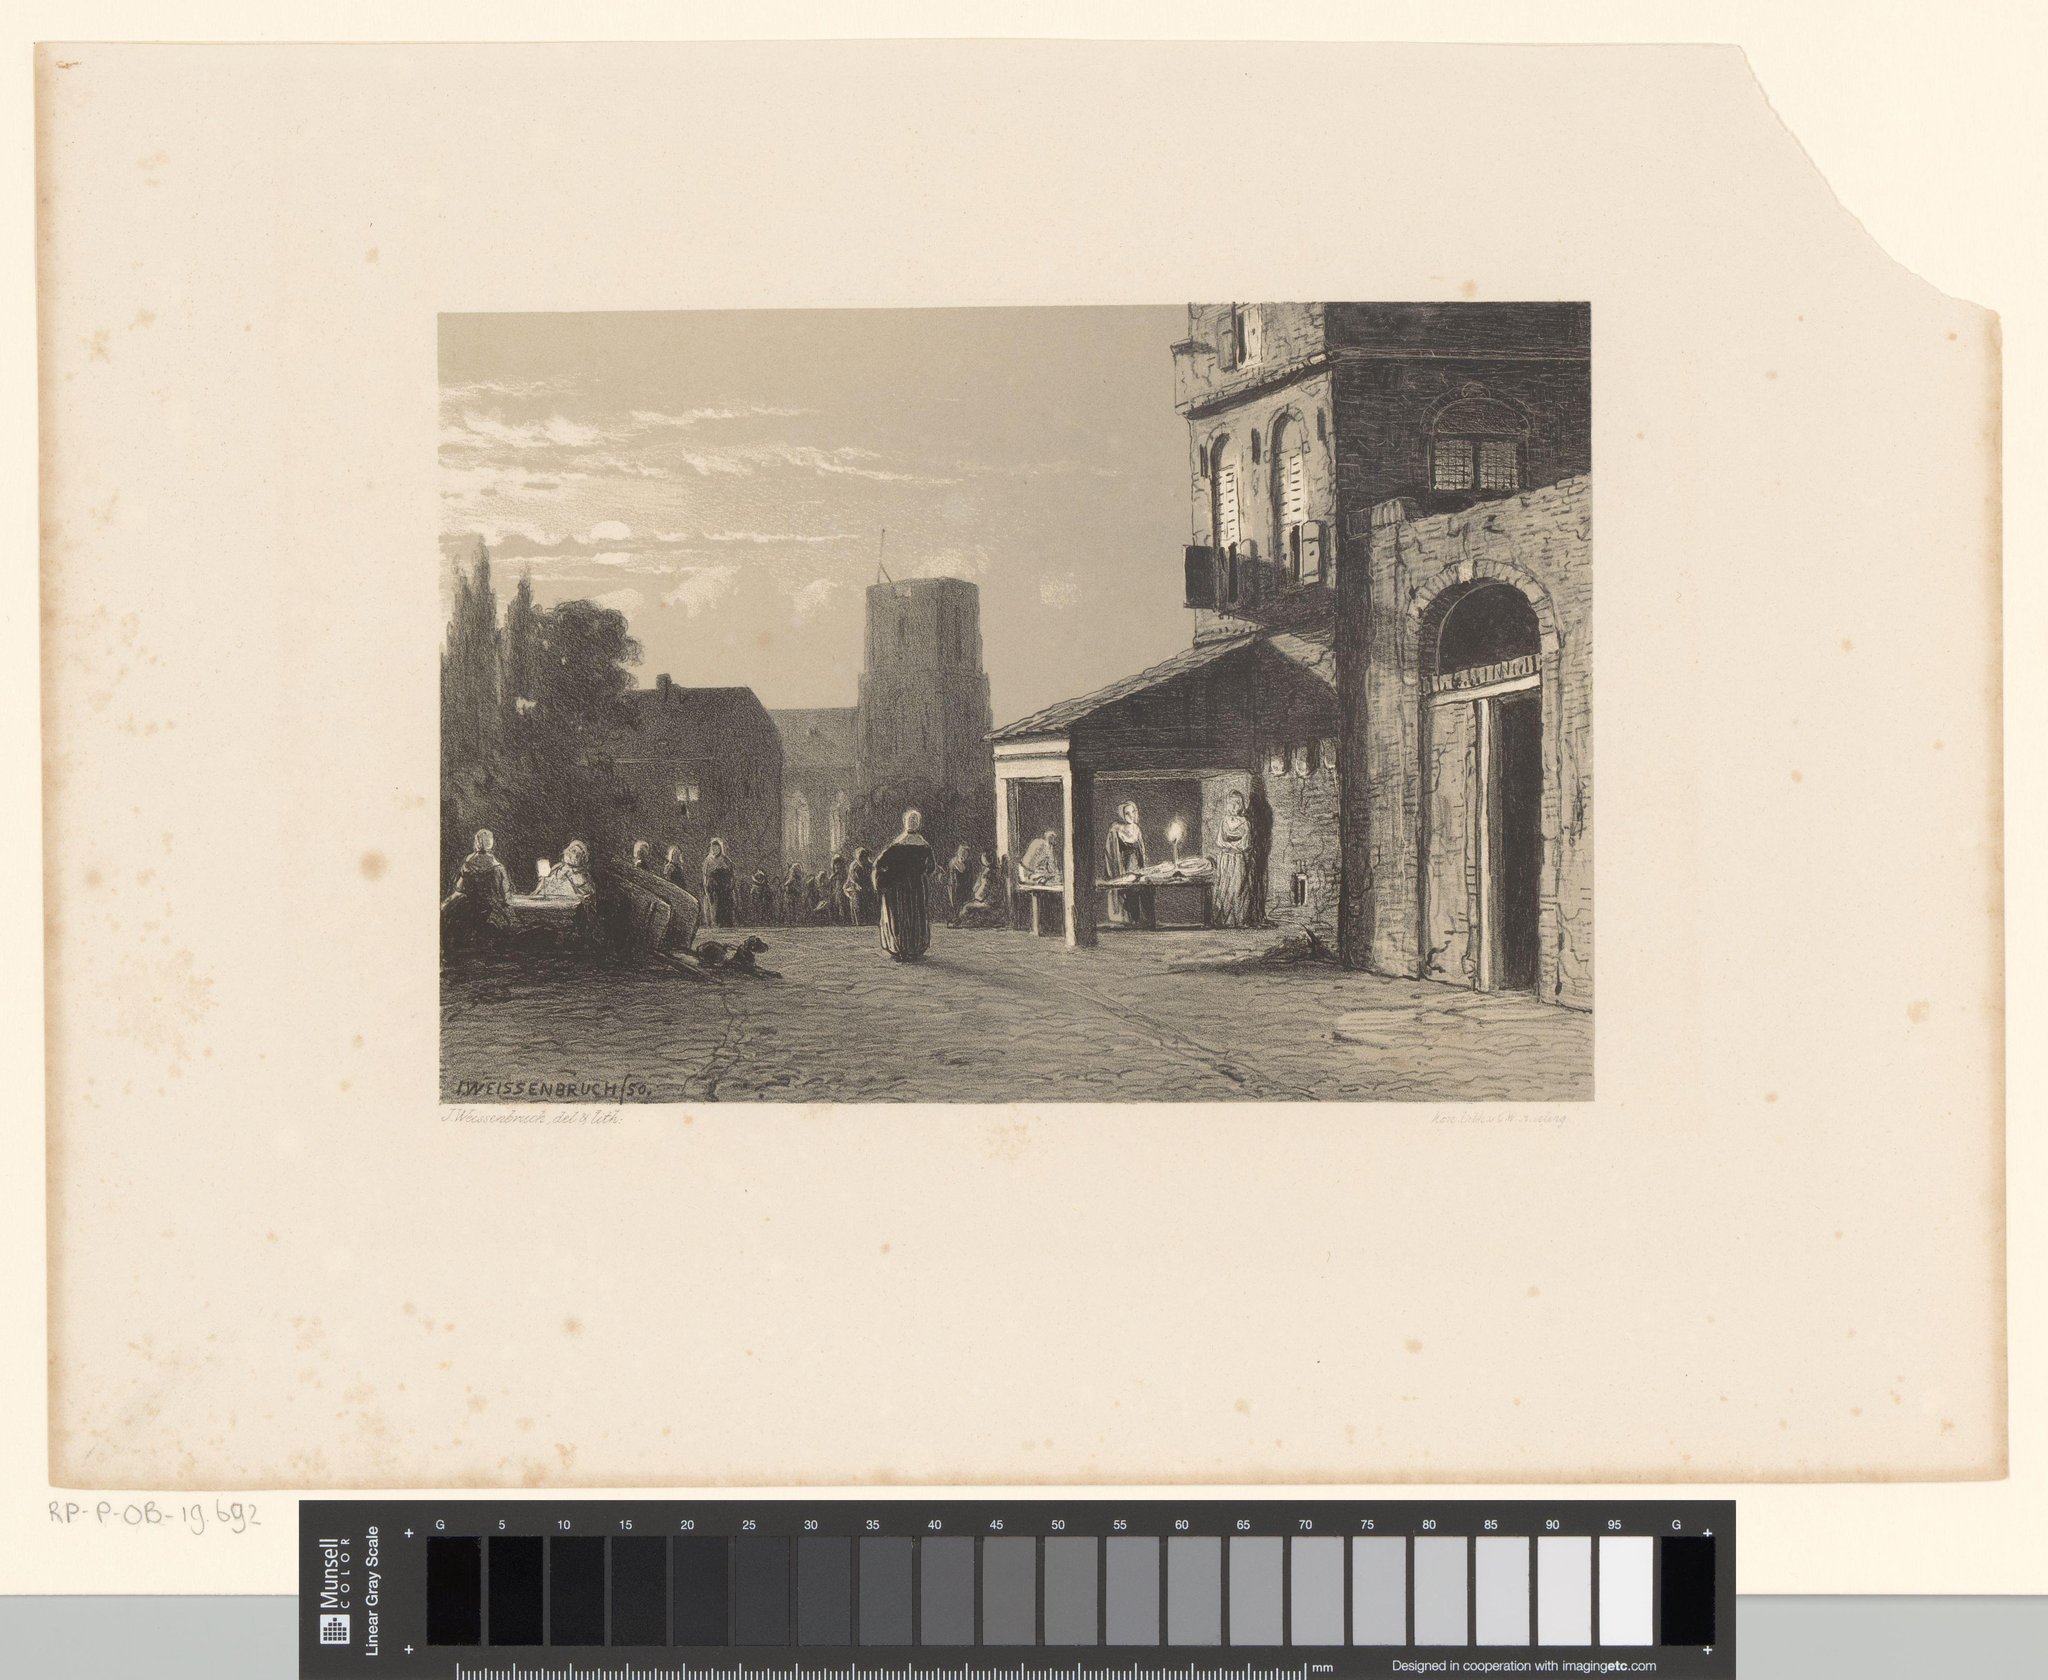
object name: print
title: Stadsgezicht bij maanlicht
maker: jan weissenbruch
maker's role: painter, print maker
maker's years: 1822-1880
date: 1850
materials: paper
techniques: tone lithography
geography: the hague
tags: city-view in general; 'veduta', moonlight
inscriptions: collector's mark: Lugt 2228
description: Een stad bij maanlicht met in de achtergrond een stompe toren. Rechts staan twee vrouwen onder een afdak bij een brandende kaars.